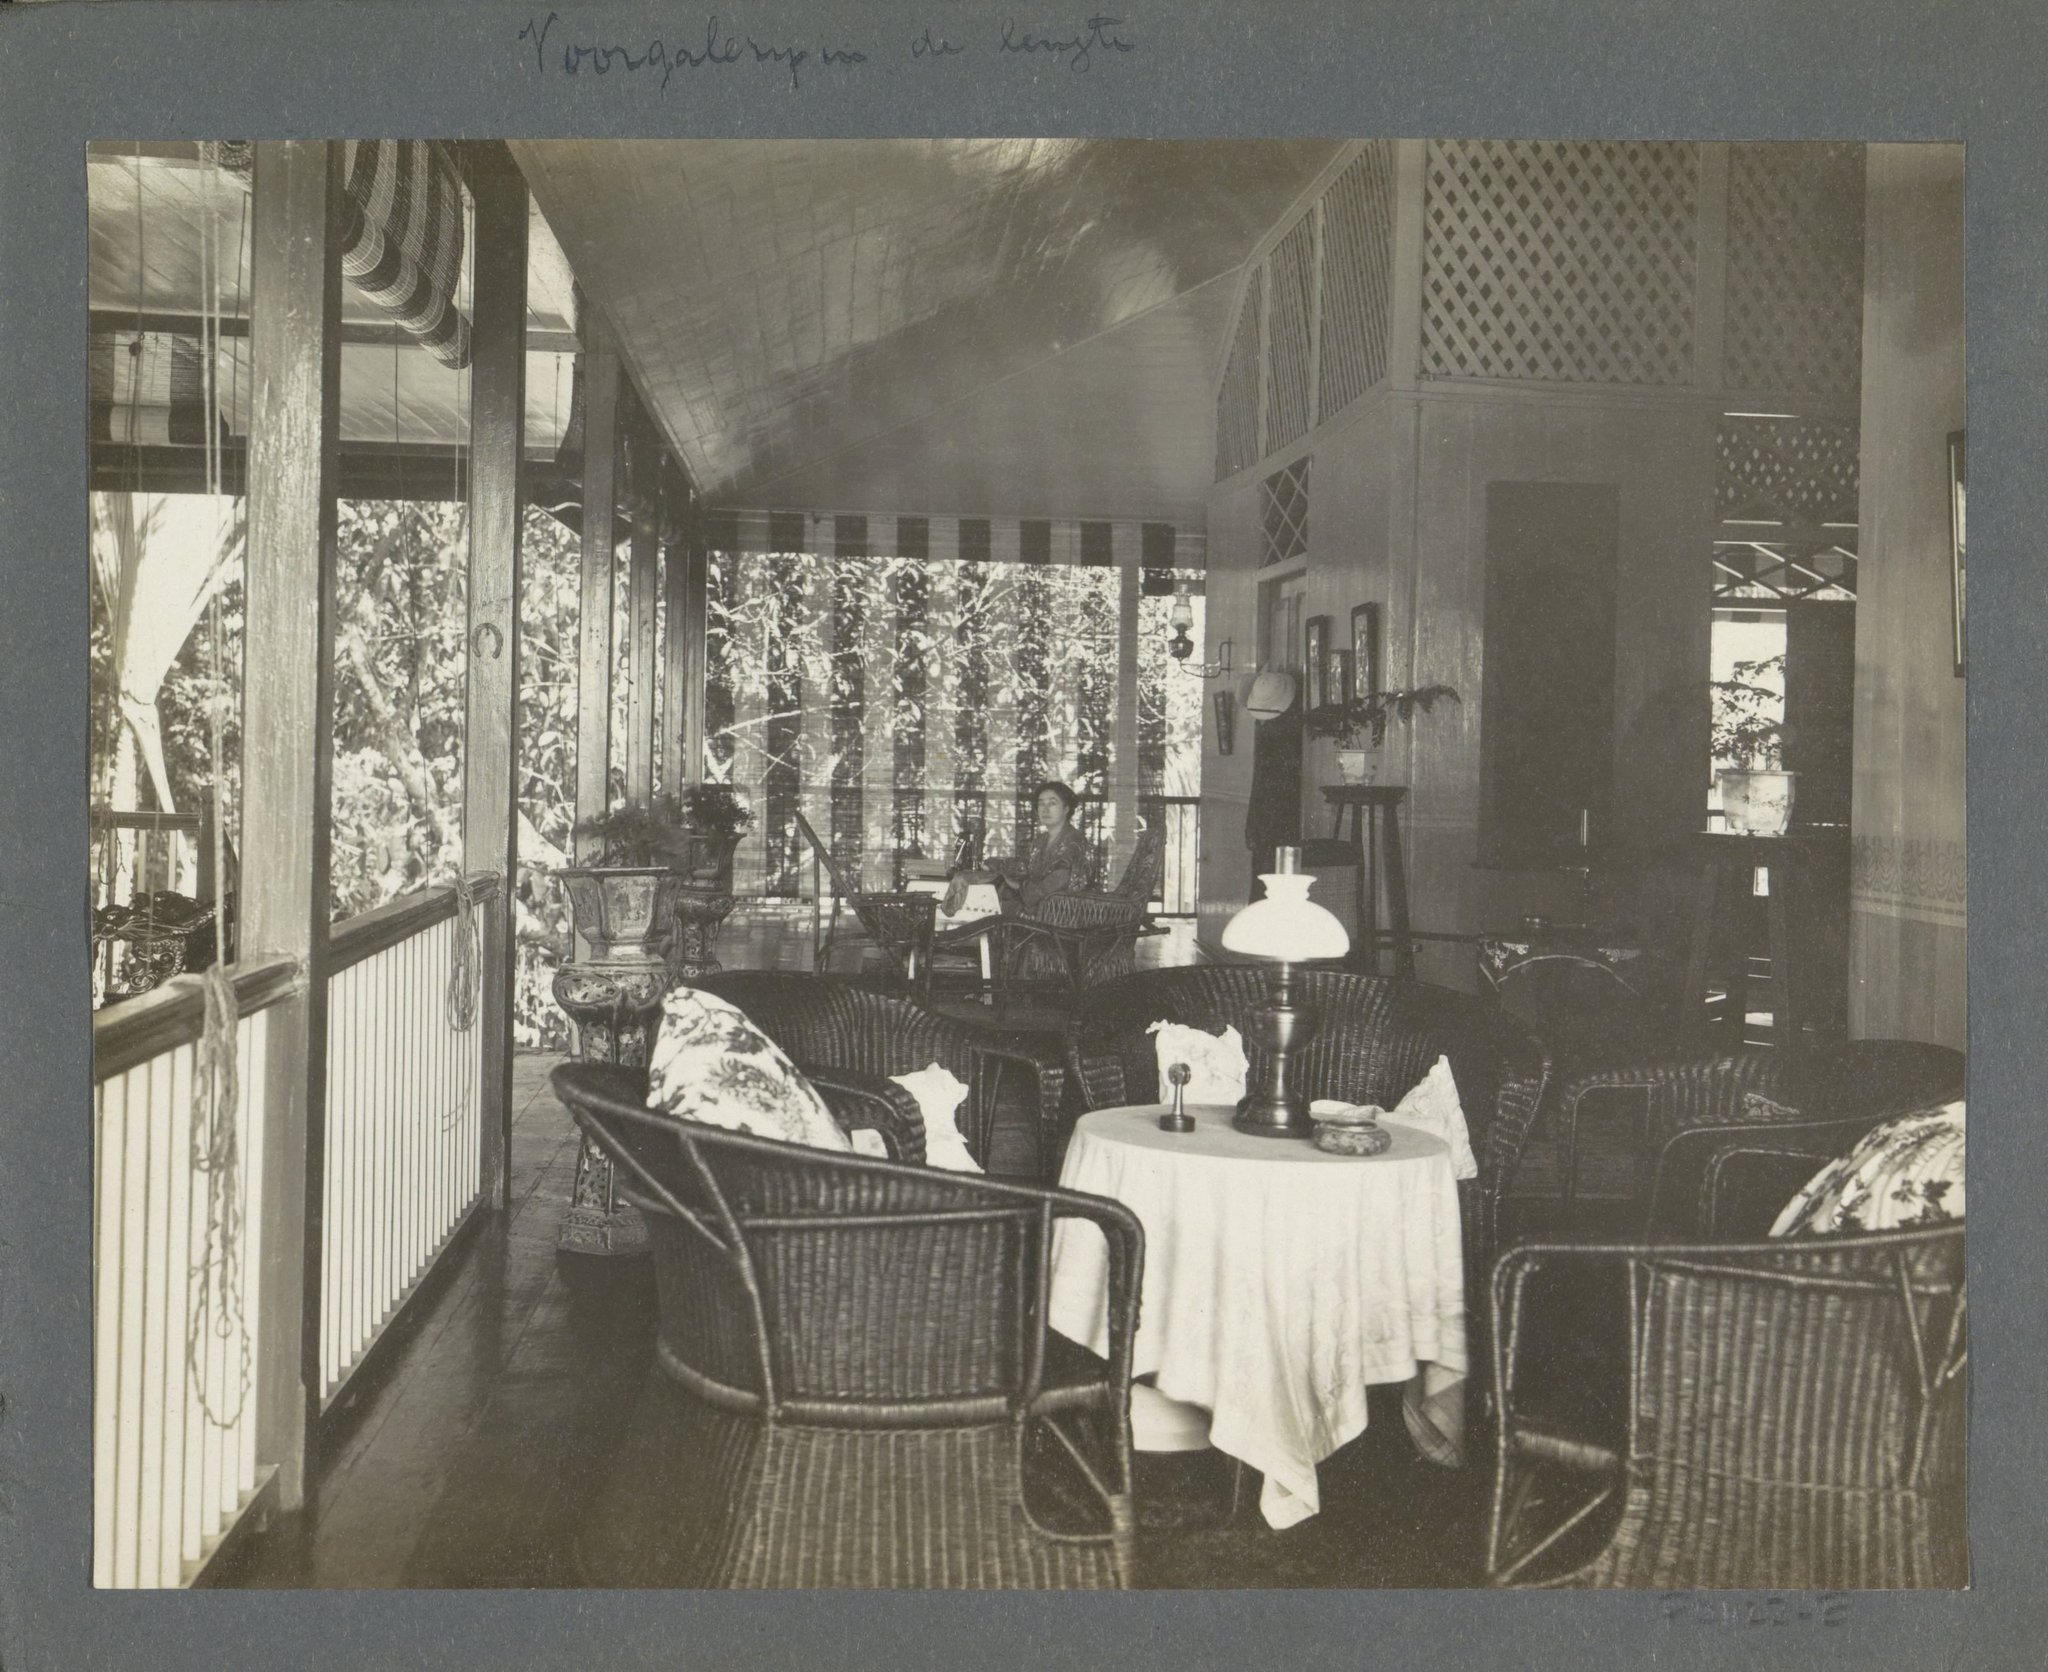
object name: photograph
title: Galerij met meubilair van een woonhuis op Sumatra, achterin Gerda Bergsma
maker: Anonymous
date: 1914-1926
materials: photographic support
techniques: gelatin silver print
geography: sumatra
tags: seating furniture, loggia, verandah, porch, sumatra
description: Onderdeel van fotoalbum met opnames van de familie Bergsma in Tandjong Poera en Rantan Pandjang (Sumatra).